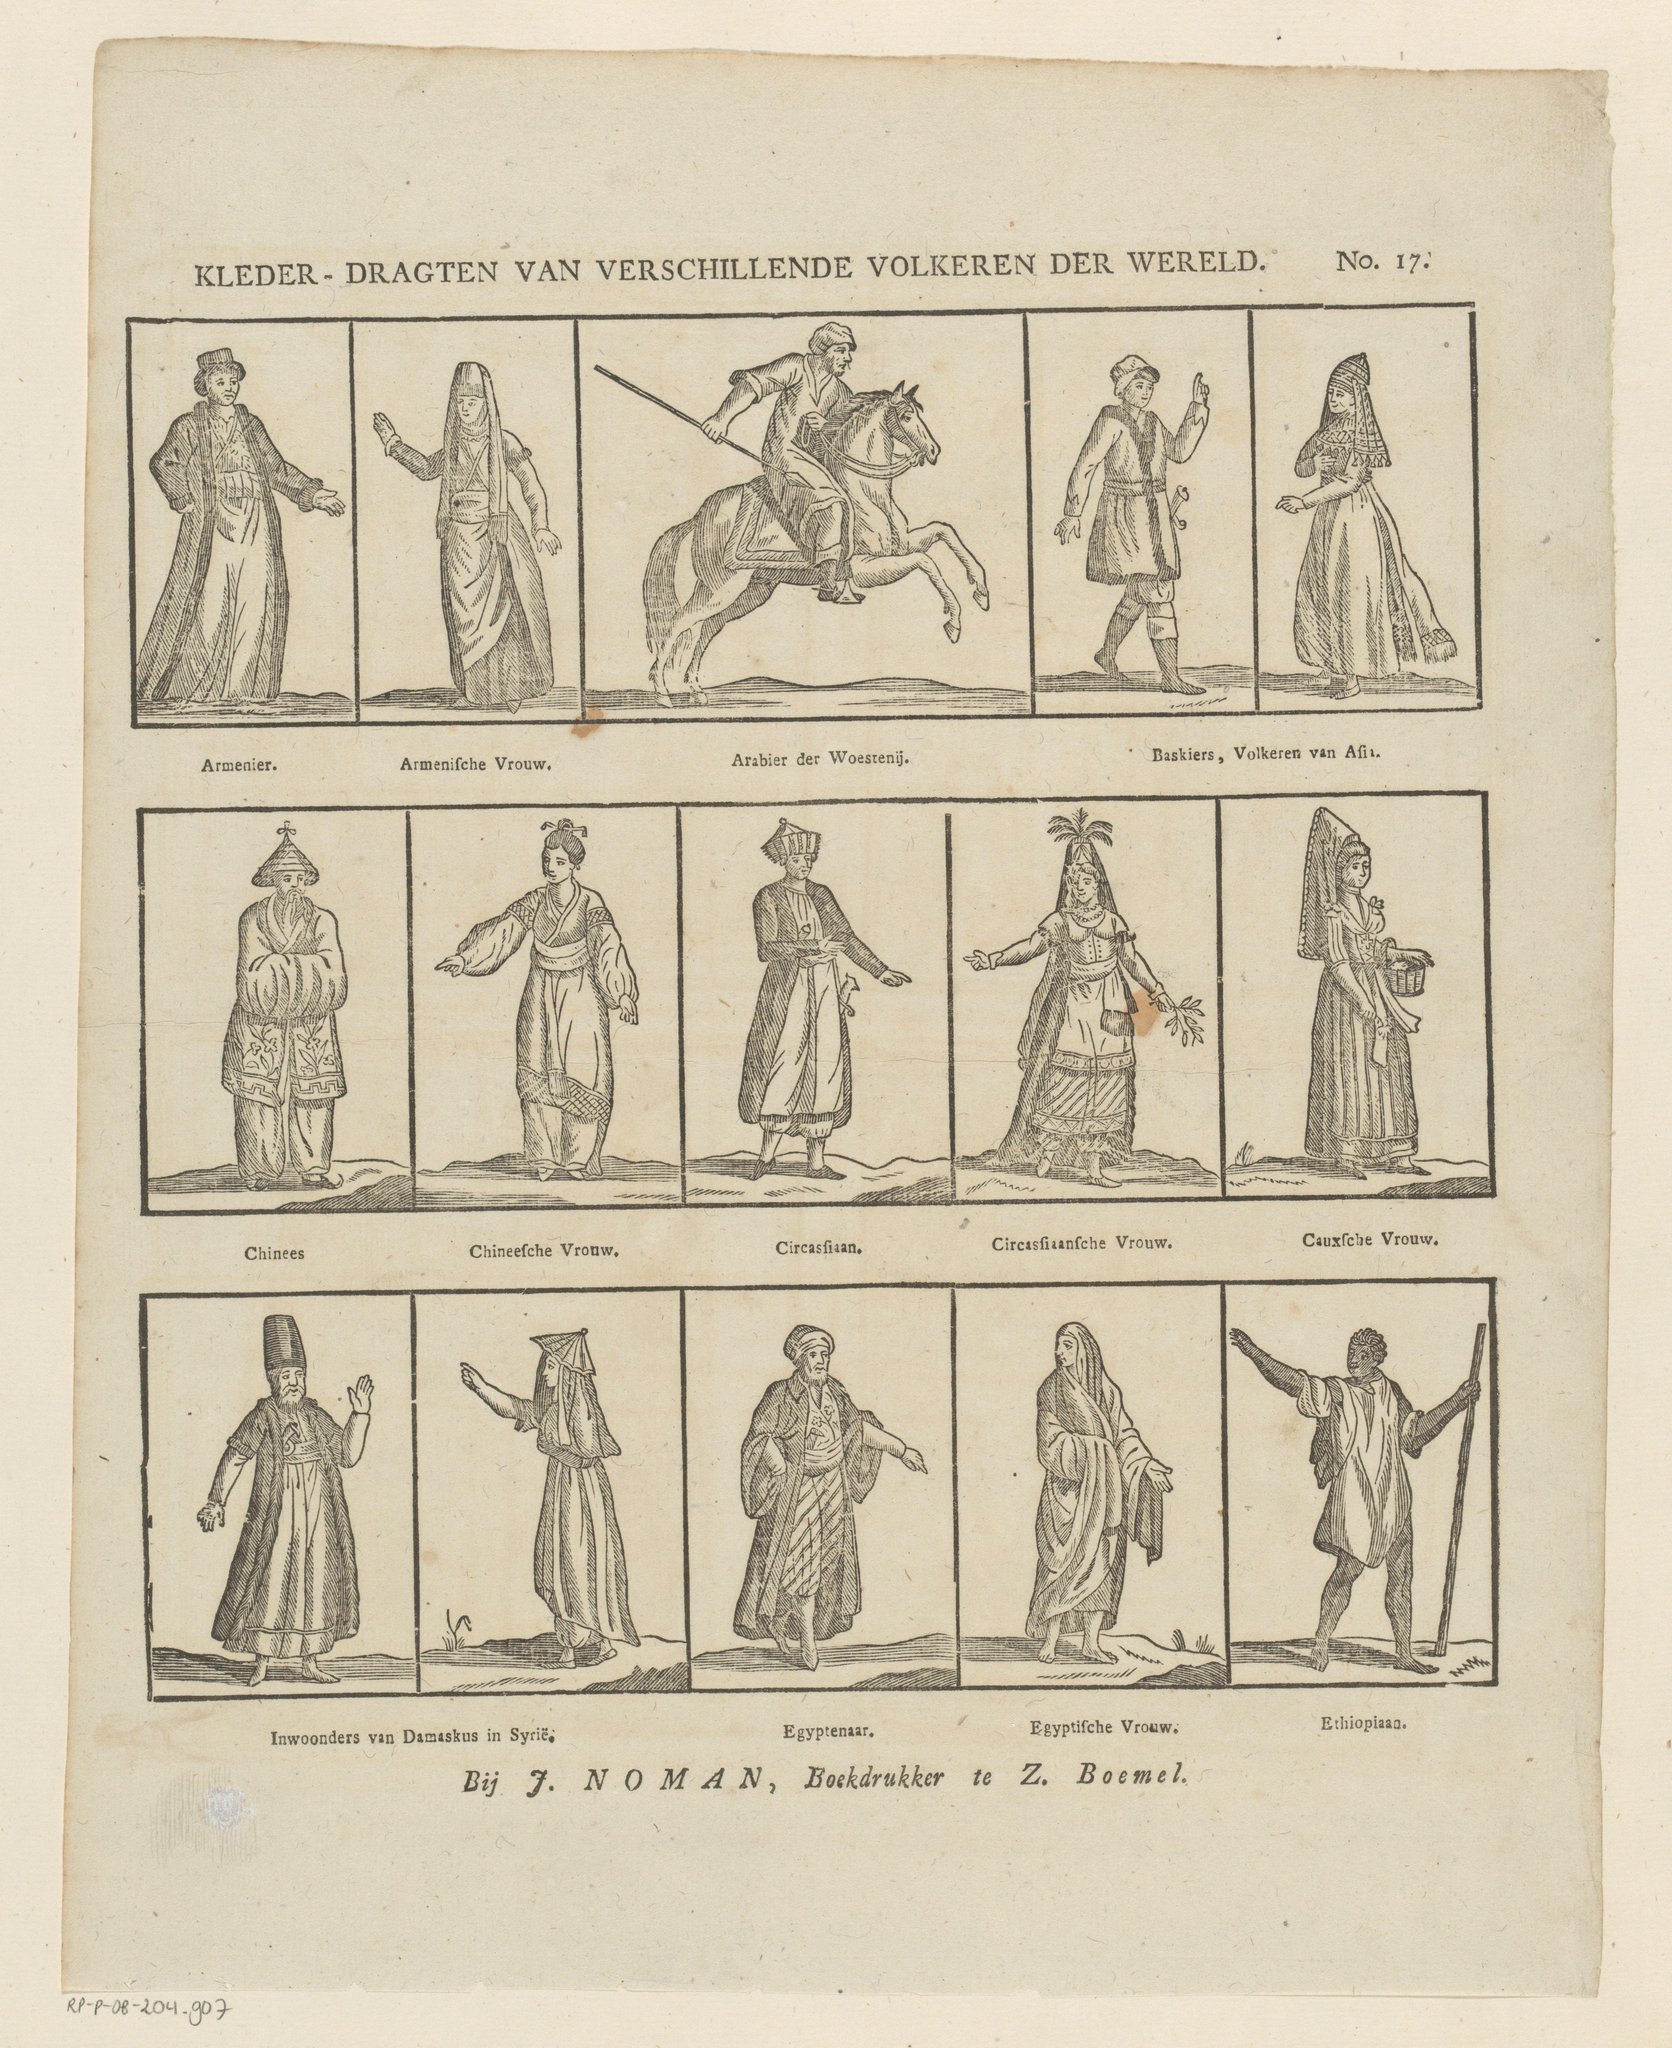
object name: popular print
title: kleder-dragten van verschillende volkeren der wereld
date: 1806-1830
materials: paper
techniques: letterpress printing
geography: zaltbommel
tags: asiatic races and peoples, africans, historical costume, folk costume, regional costume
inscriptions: collector's mark: Lugt 2760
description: Blad met 3 houtsneden met elk vijf voorstellingen van klederdrachten van verschillende volkeren, waaronder klederdracht uit China en Egypte. Onder elke voorstelling een onderschrift. Genummerd rechtsboven: No. 17.